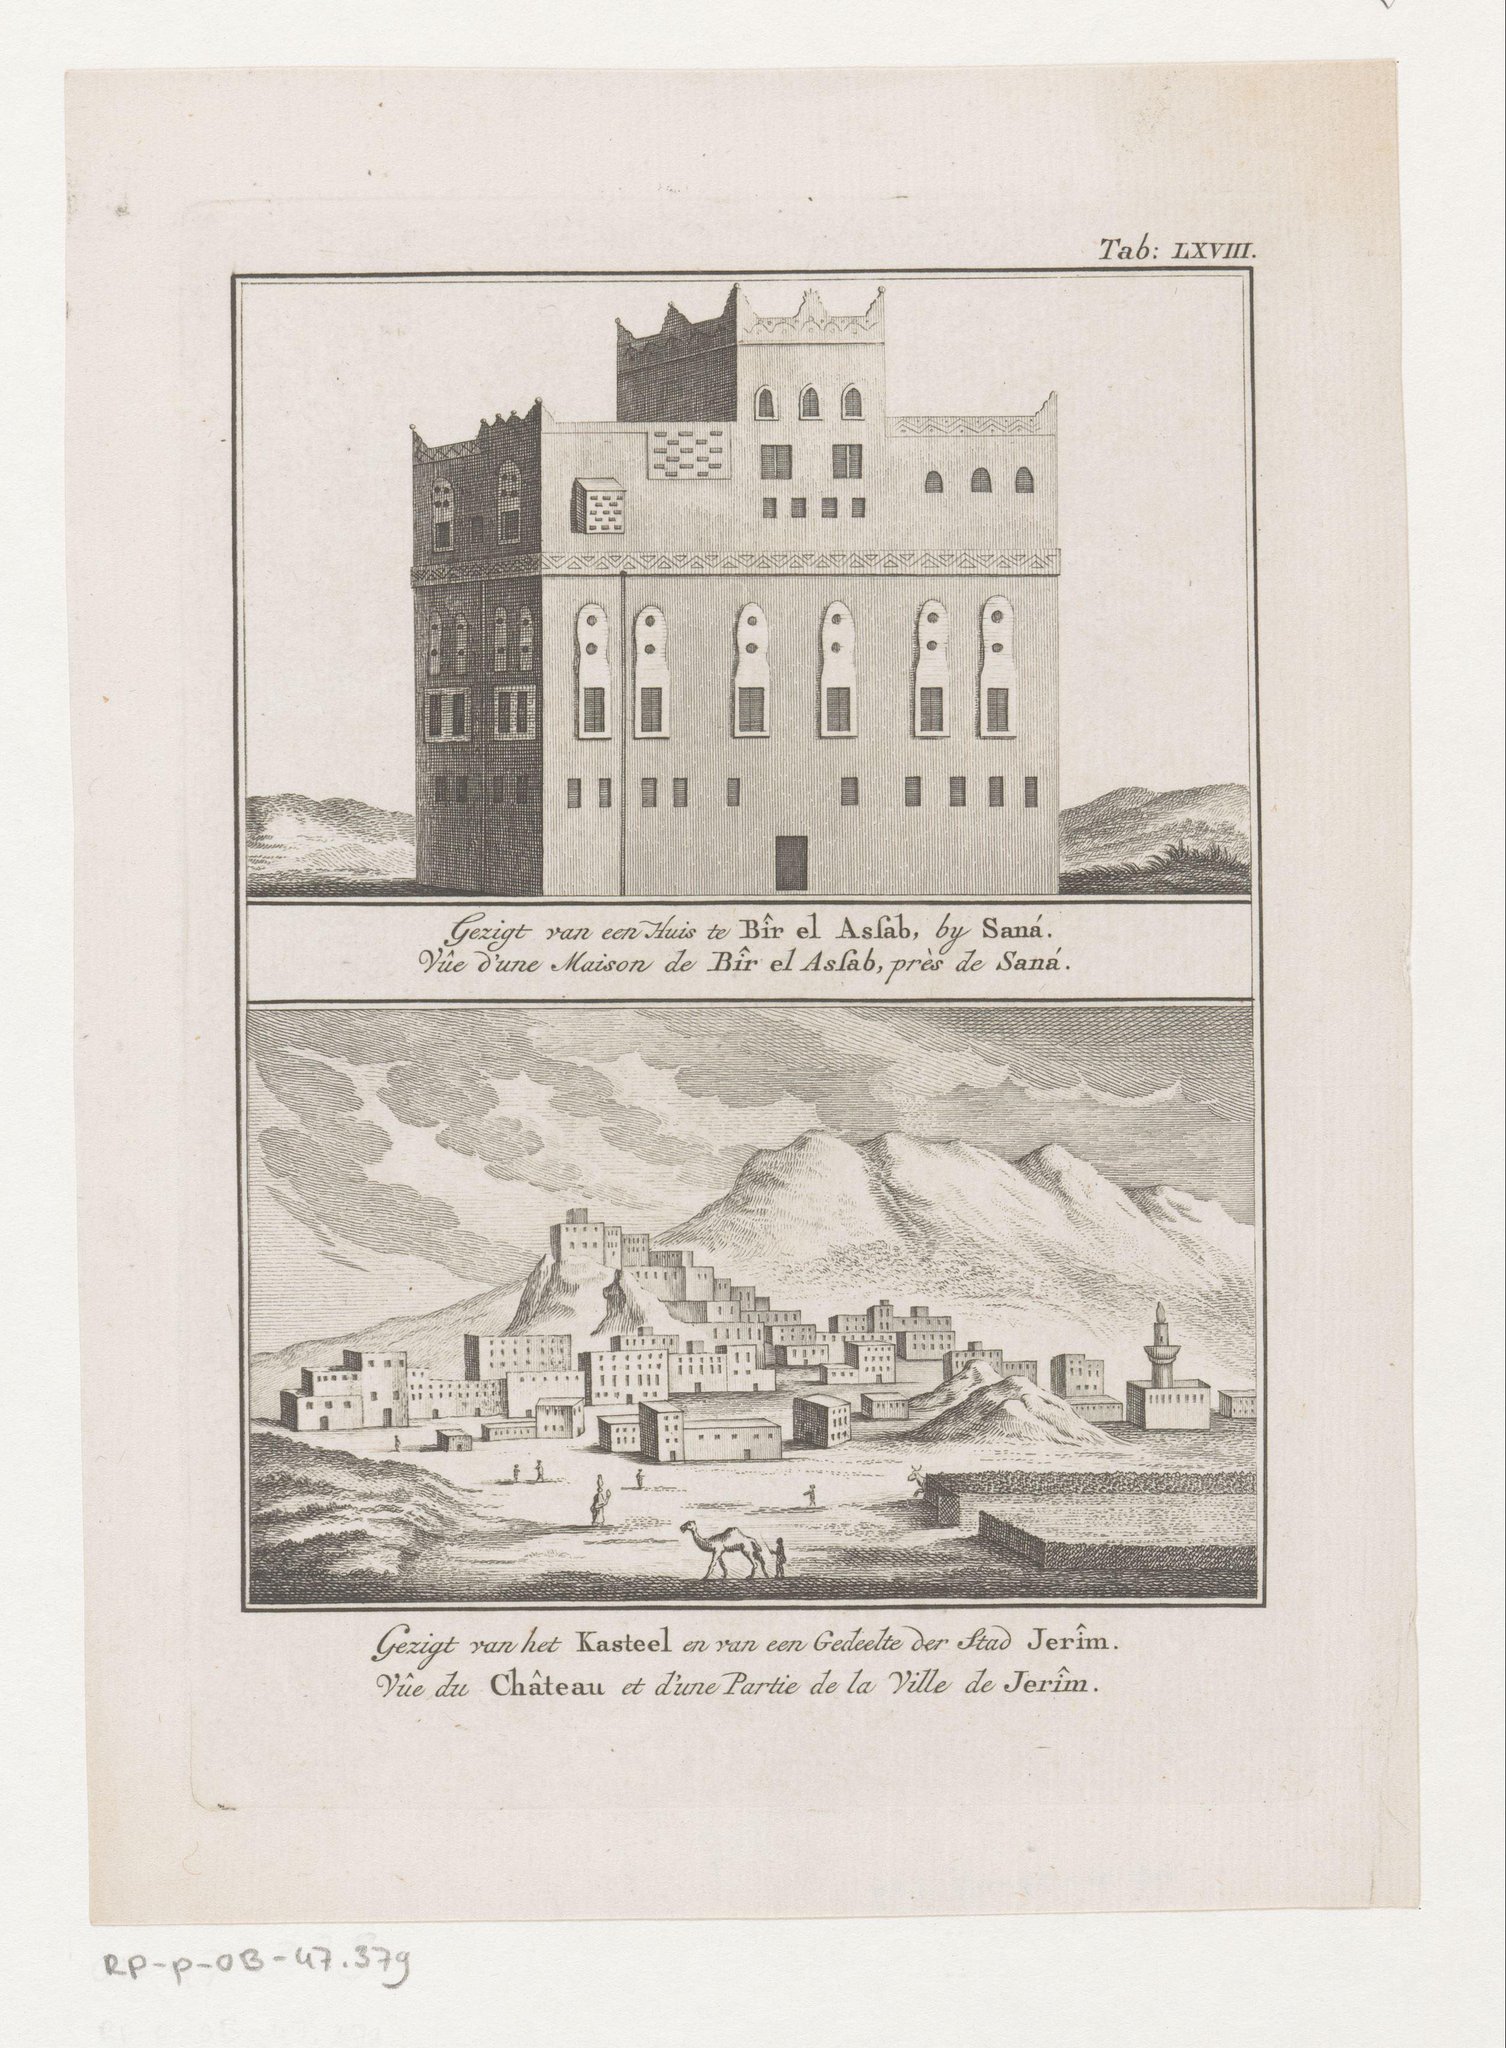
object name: print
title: Gezichten op bebouwing in Jemen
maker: Anonymous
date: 1776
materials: paper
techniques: etching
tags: castle, prospect of city, town panorama, silhouette of city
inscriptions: collector's mark: Lugt 2228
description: Prent uit: Niebuhr, Carsten van. Reize naar Arabie en andere omliggende landen, van Carsten Niebuhr uit het Hoogduitsch vertaald, Amsterdam: S.J. Baalde. Utrecht: J. van Schoonhoven & comp., 1776.